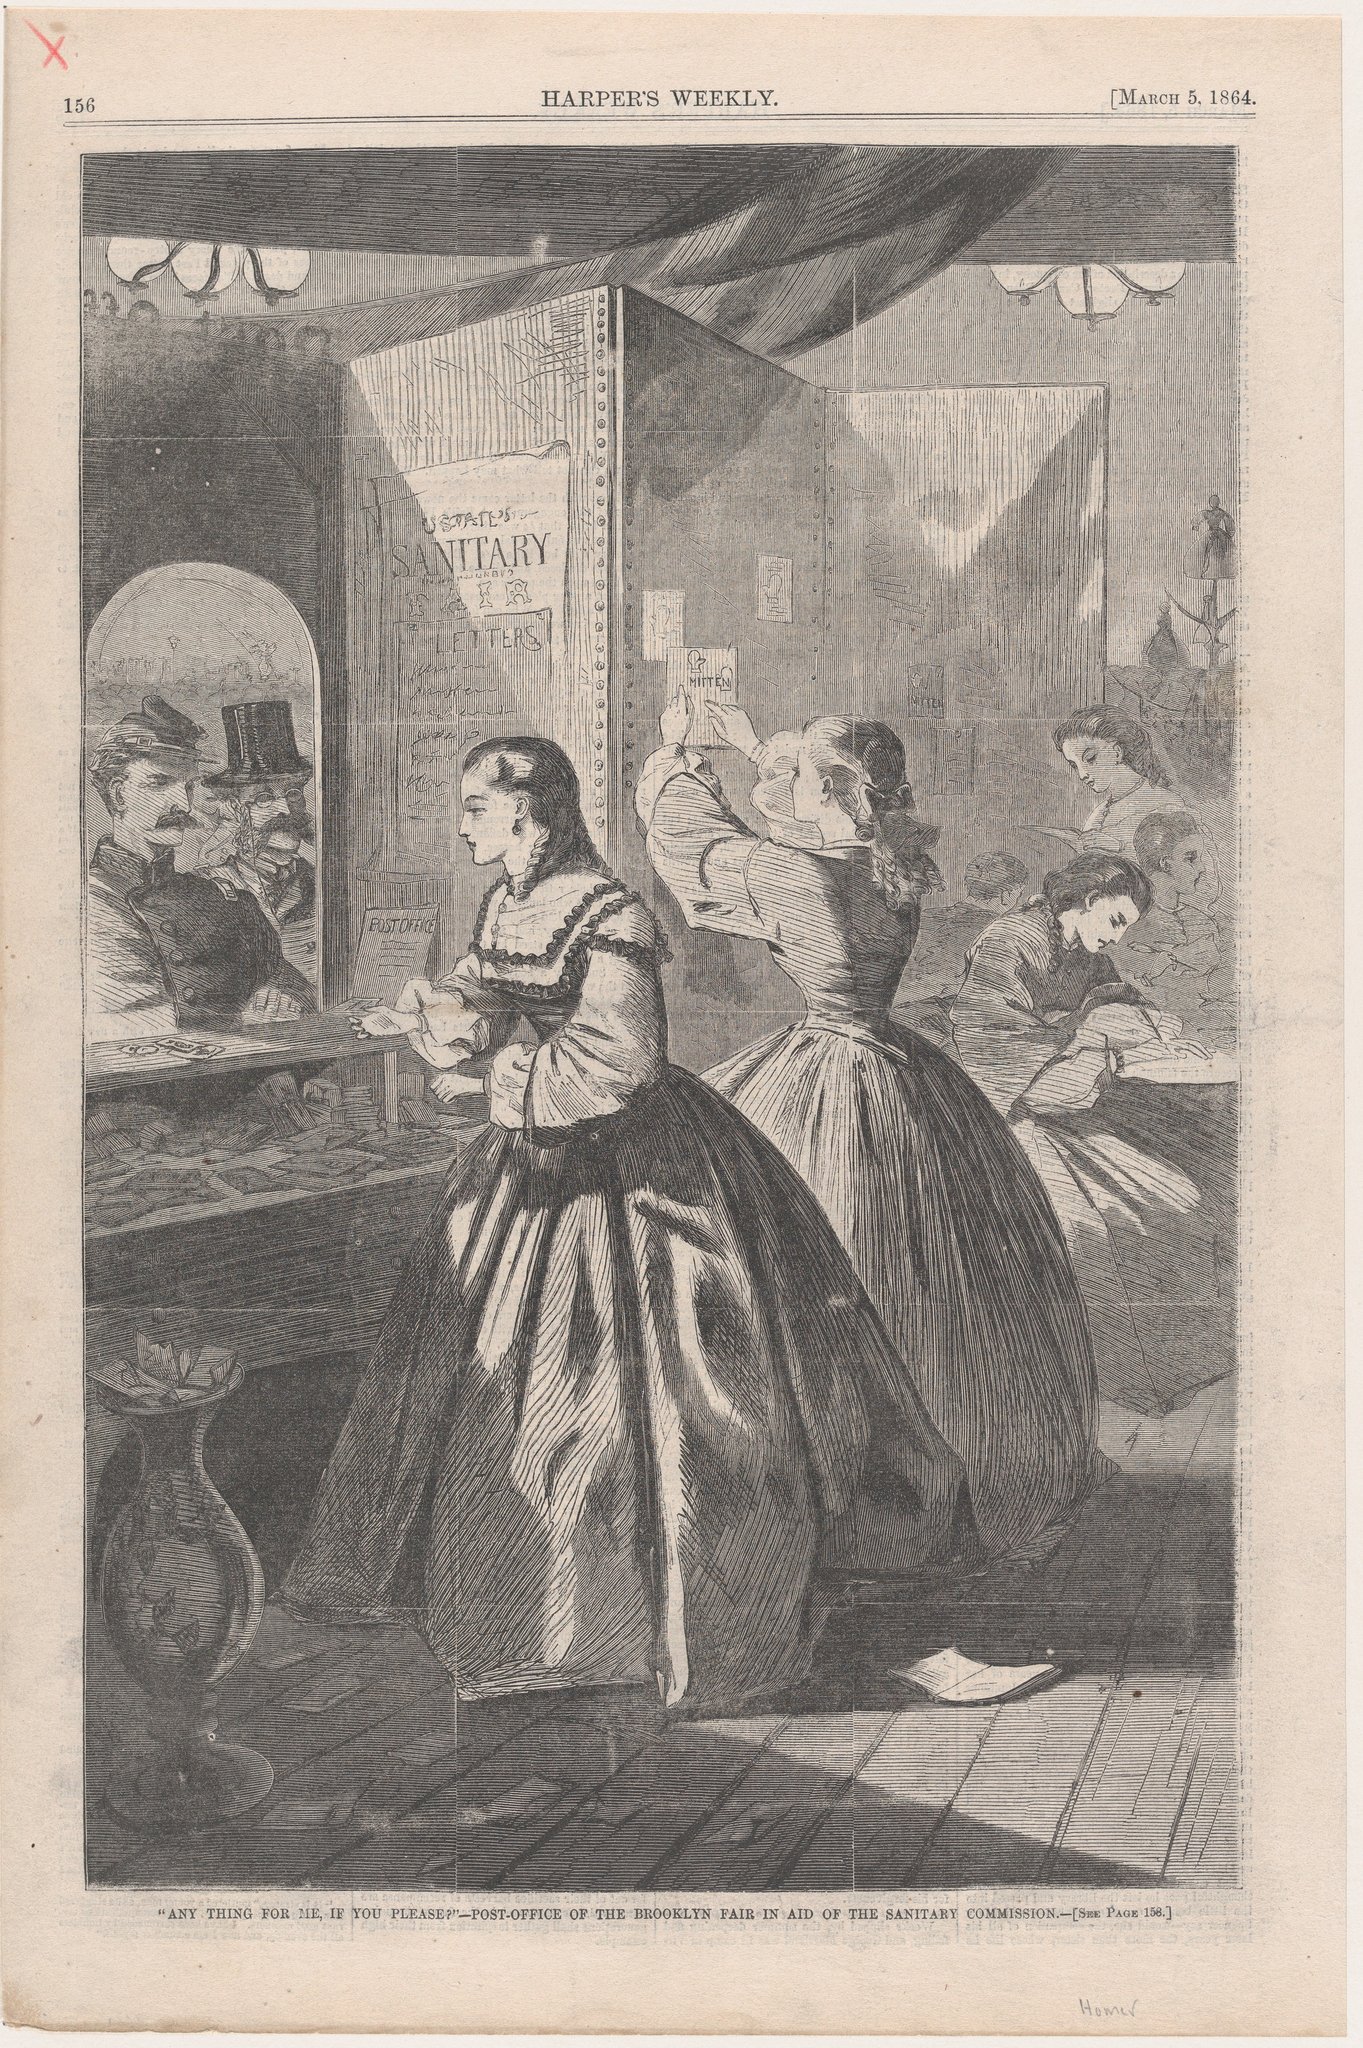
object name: print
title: "Any Thing for Me, if you Please?" Post-Office of the Brooklyn Fair in Aid of the Sanitary Commission (from "Harper's Weekly," Vol. VIII)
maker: winslow homer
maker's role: artist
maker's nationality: american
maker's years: 1836-1910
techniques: engraving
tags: post offices,american civil war,men,women,writing